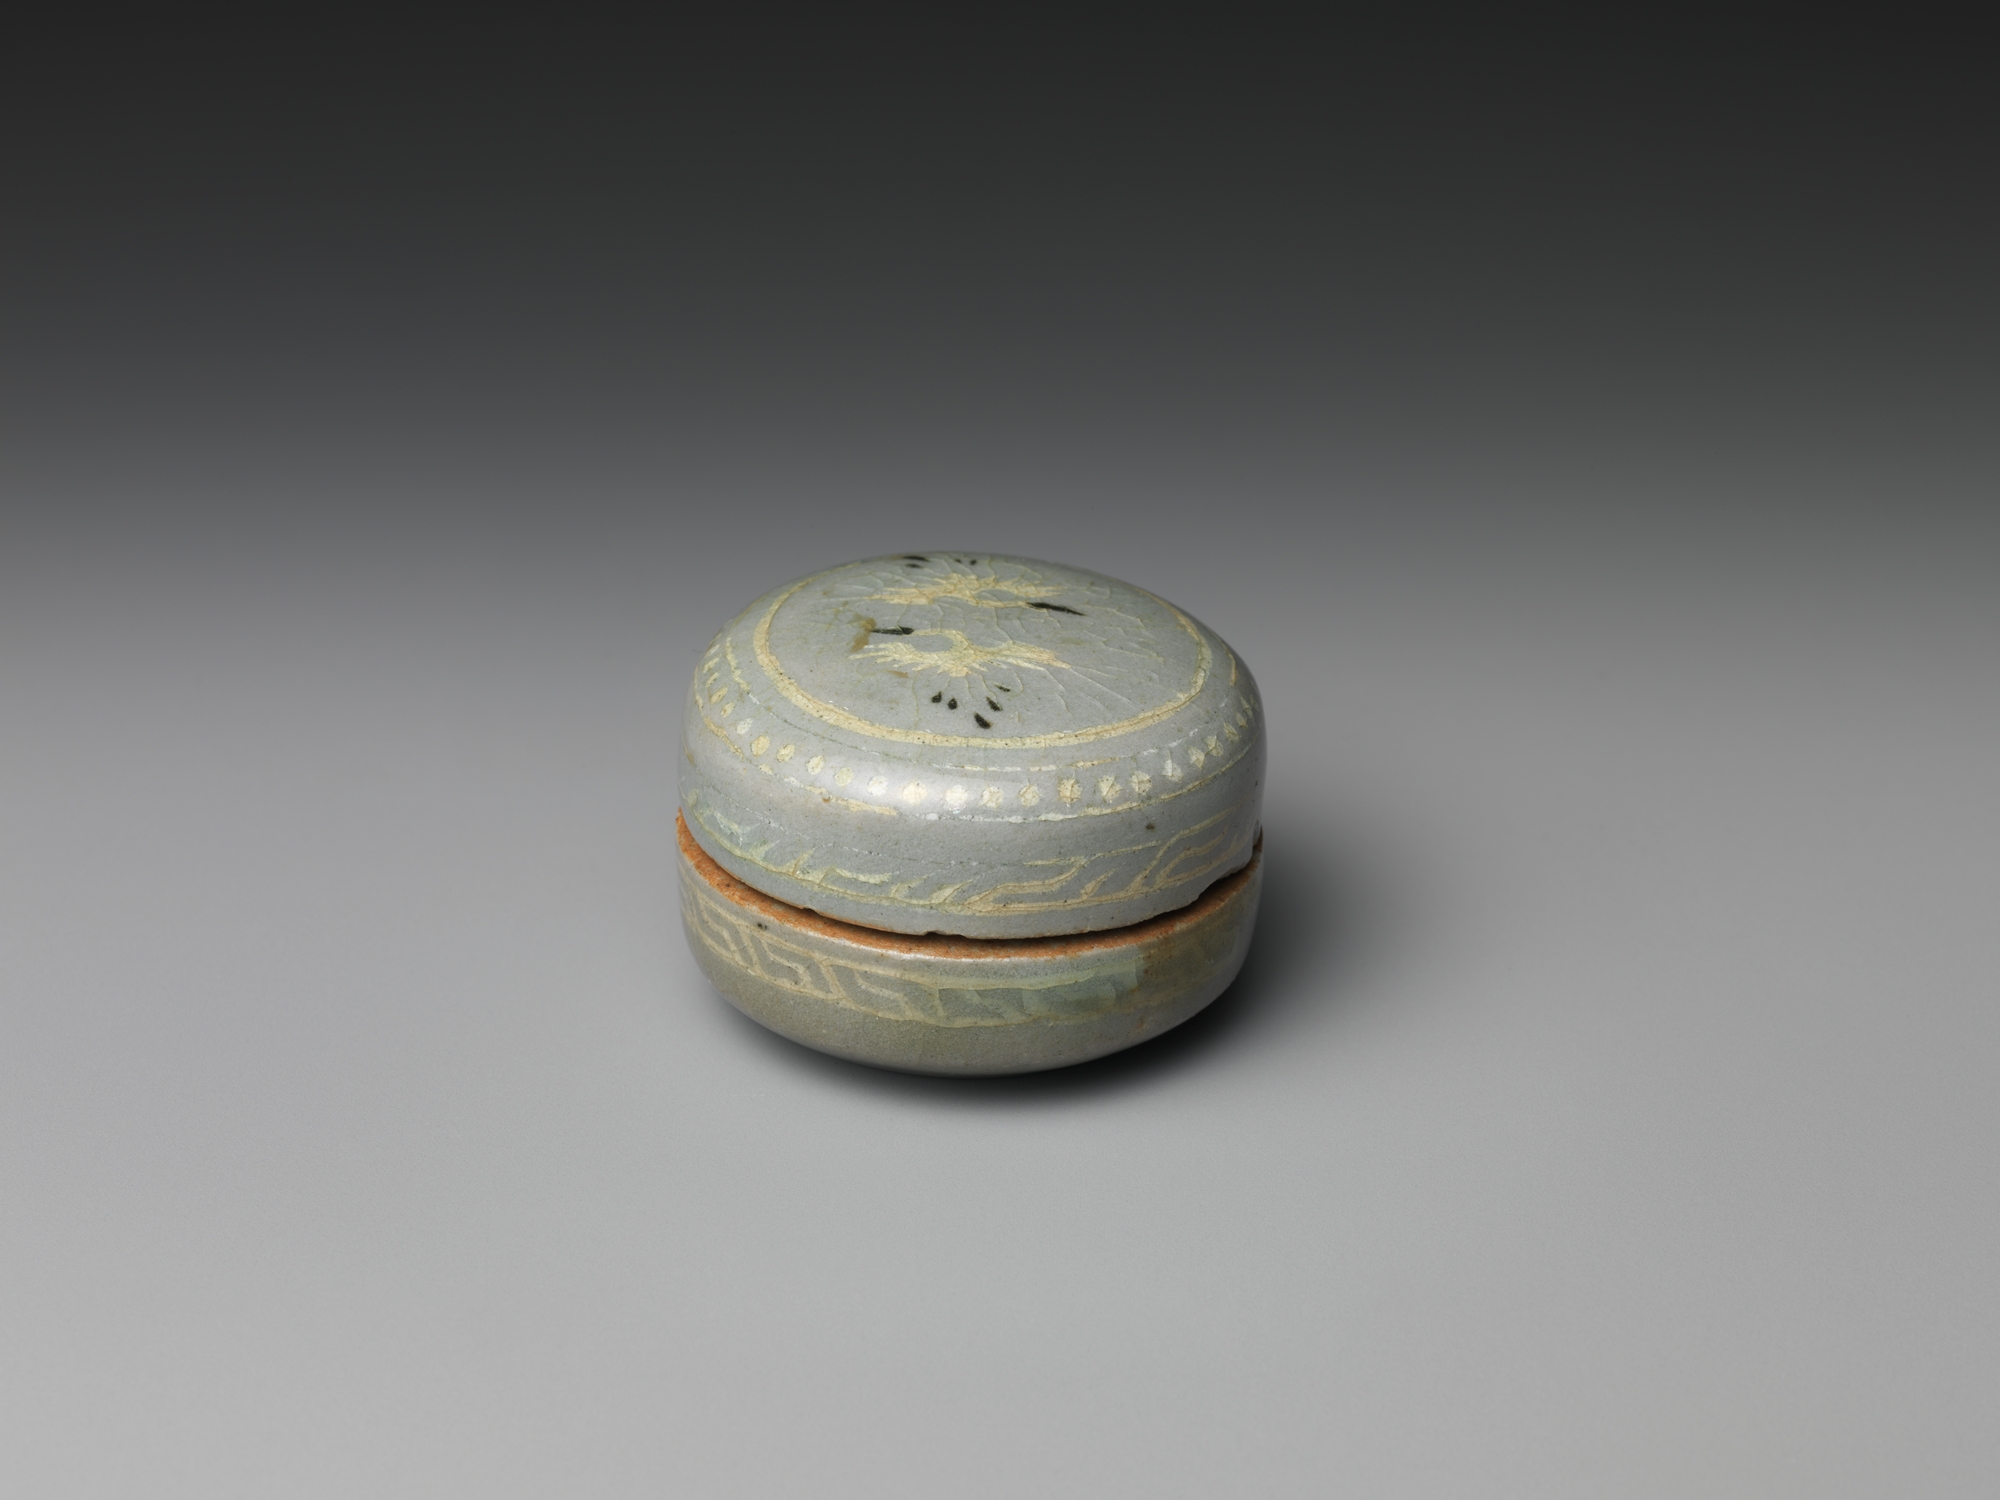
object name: box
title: Box from set of five decorated with cranes and clouds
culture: korean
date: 1201-1400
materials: ceramic glaze, glaze, stoneware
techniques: inlay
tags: cranes